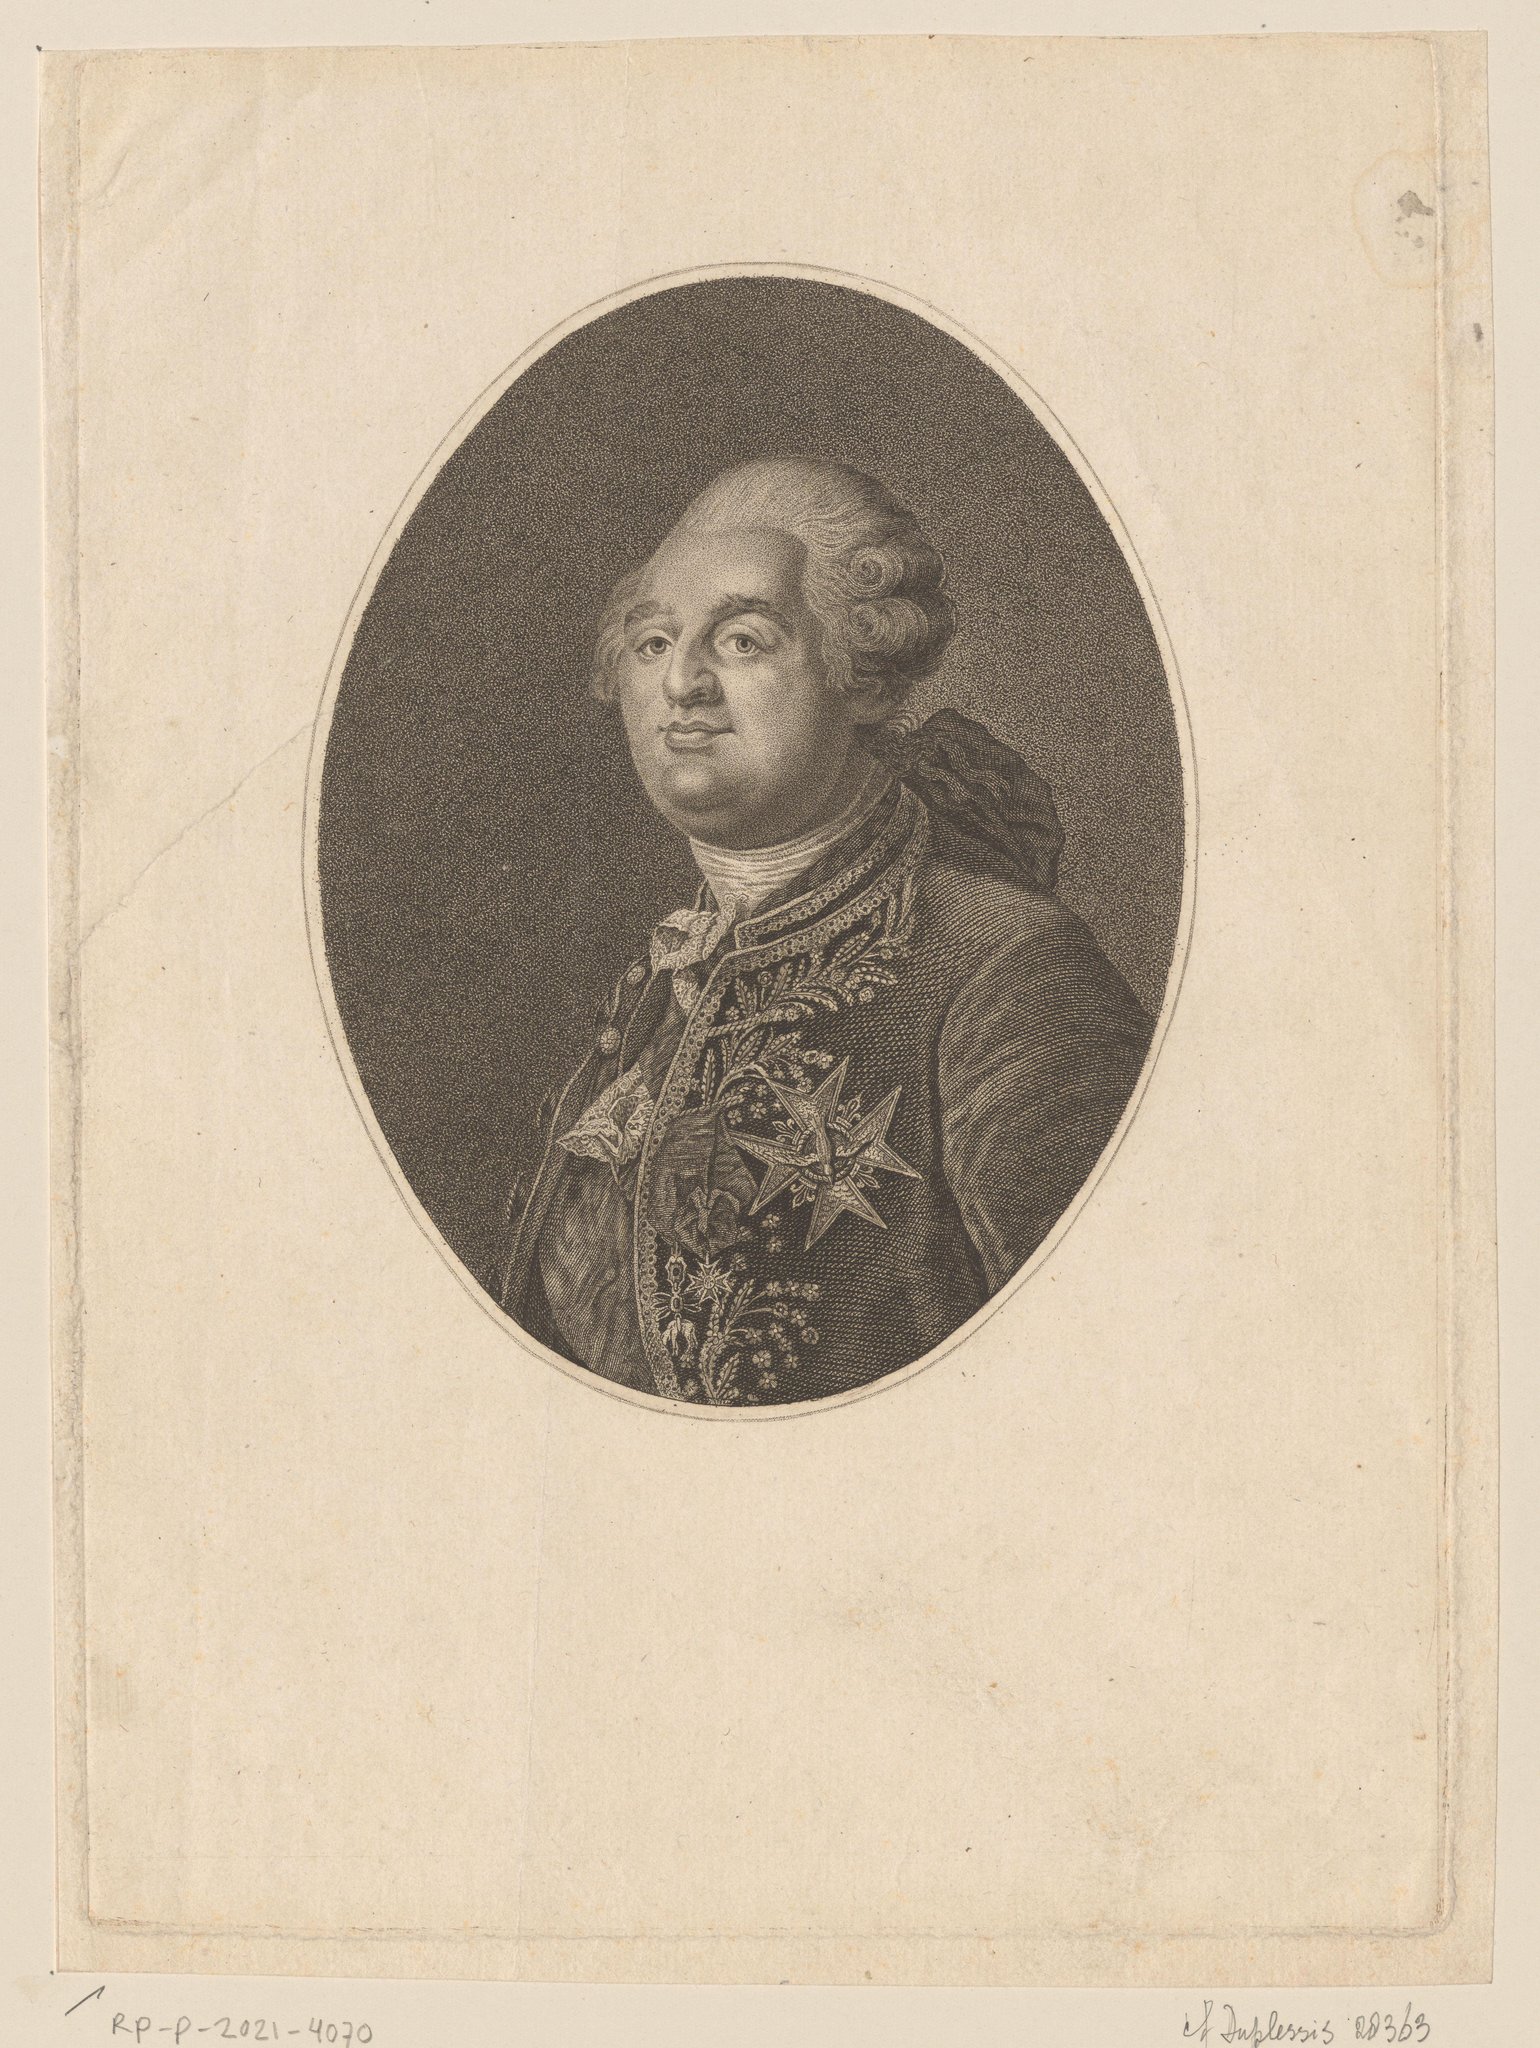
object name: print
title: Portret van Lodewijk XVI van Frankrijk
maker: Anonymous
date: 1784-1799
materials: paper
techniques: etching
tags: paris, lodewijk xvi (koning van frankrijk), historical persons, wig, knighthood order of the golden fleece - insignia of a knighthood order, e.g.: badge, chain (with name of order), king